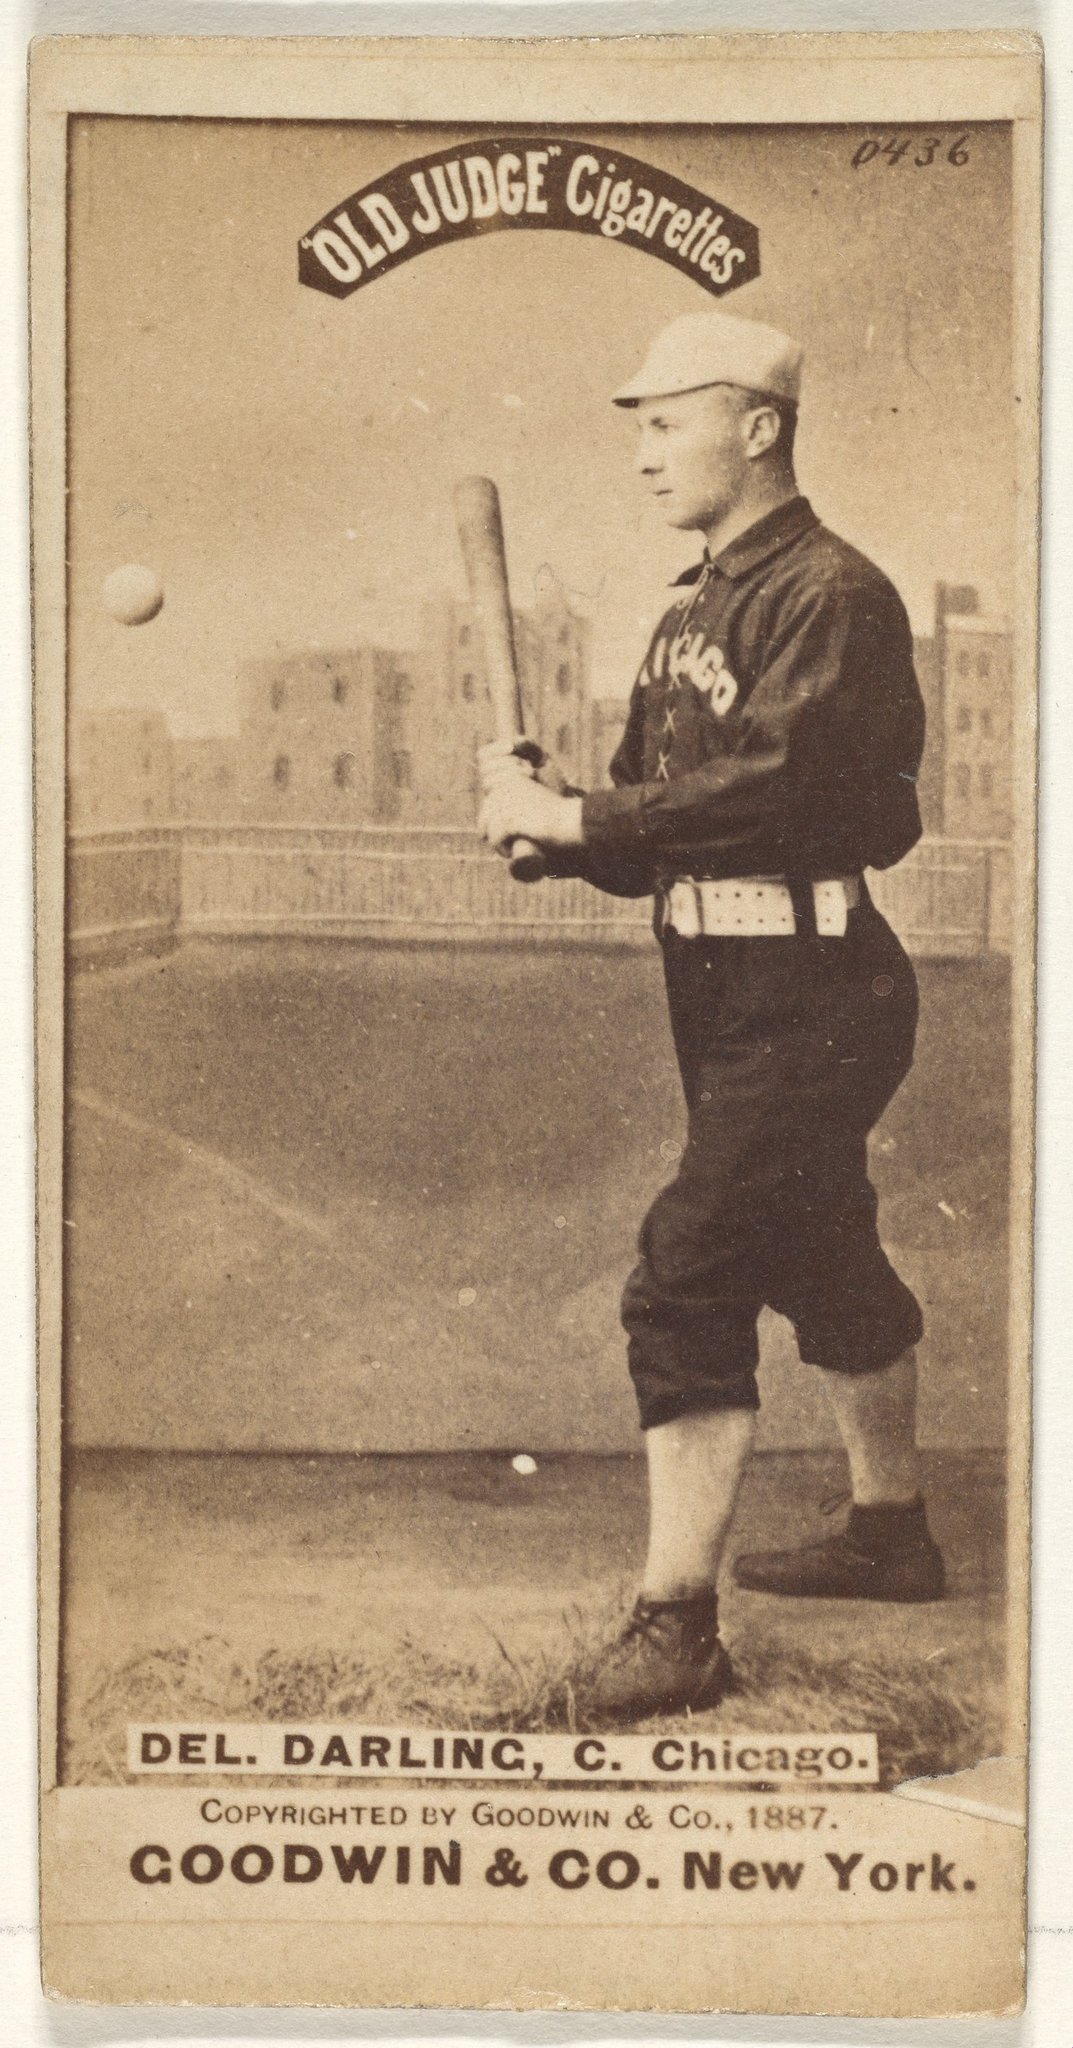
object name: baseball card, photograph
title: Dell Darling, Catcher, Chicago, from the Old Judge series (N172) for Old Judge Cigarettes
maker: goodwin & company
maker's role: publisher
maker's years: 1850-1950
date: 1887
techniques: albumen silver print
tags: men,portraits,baseball,athletes